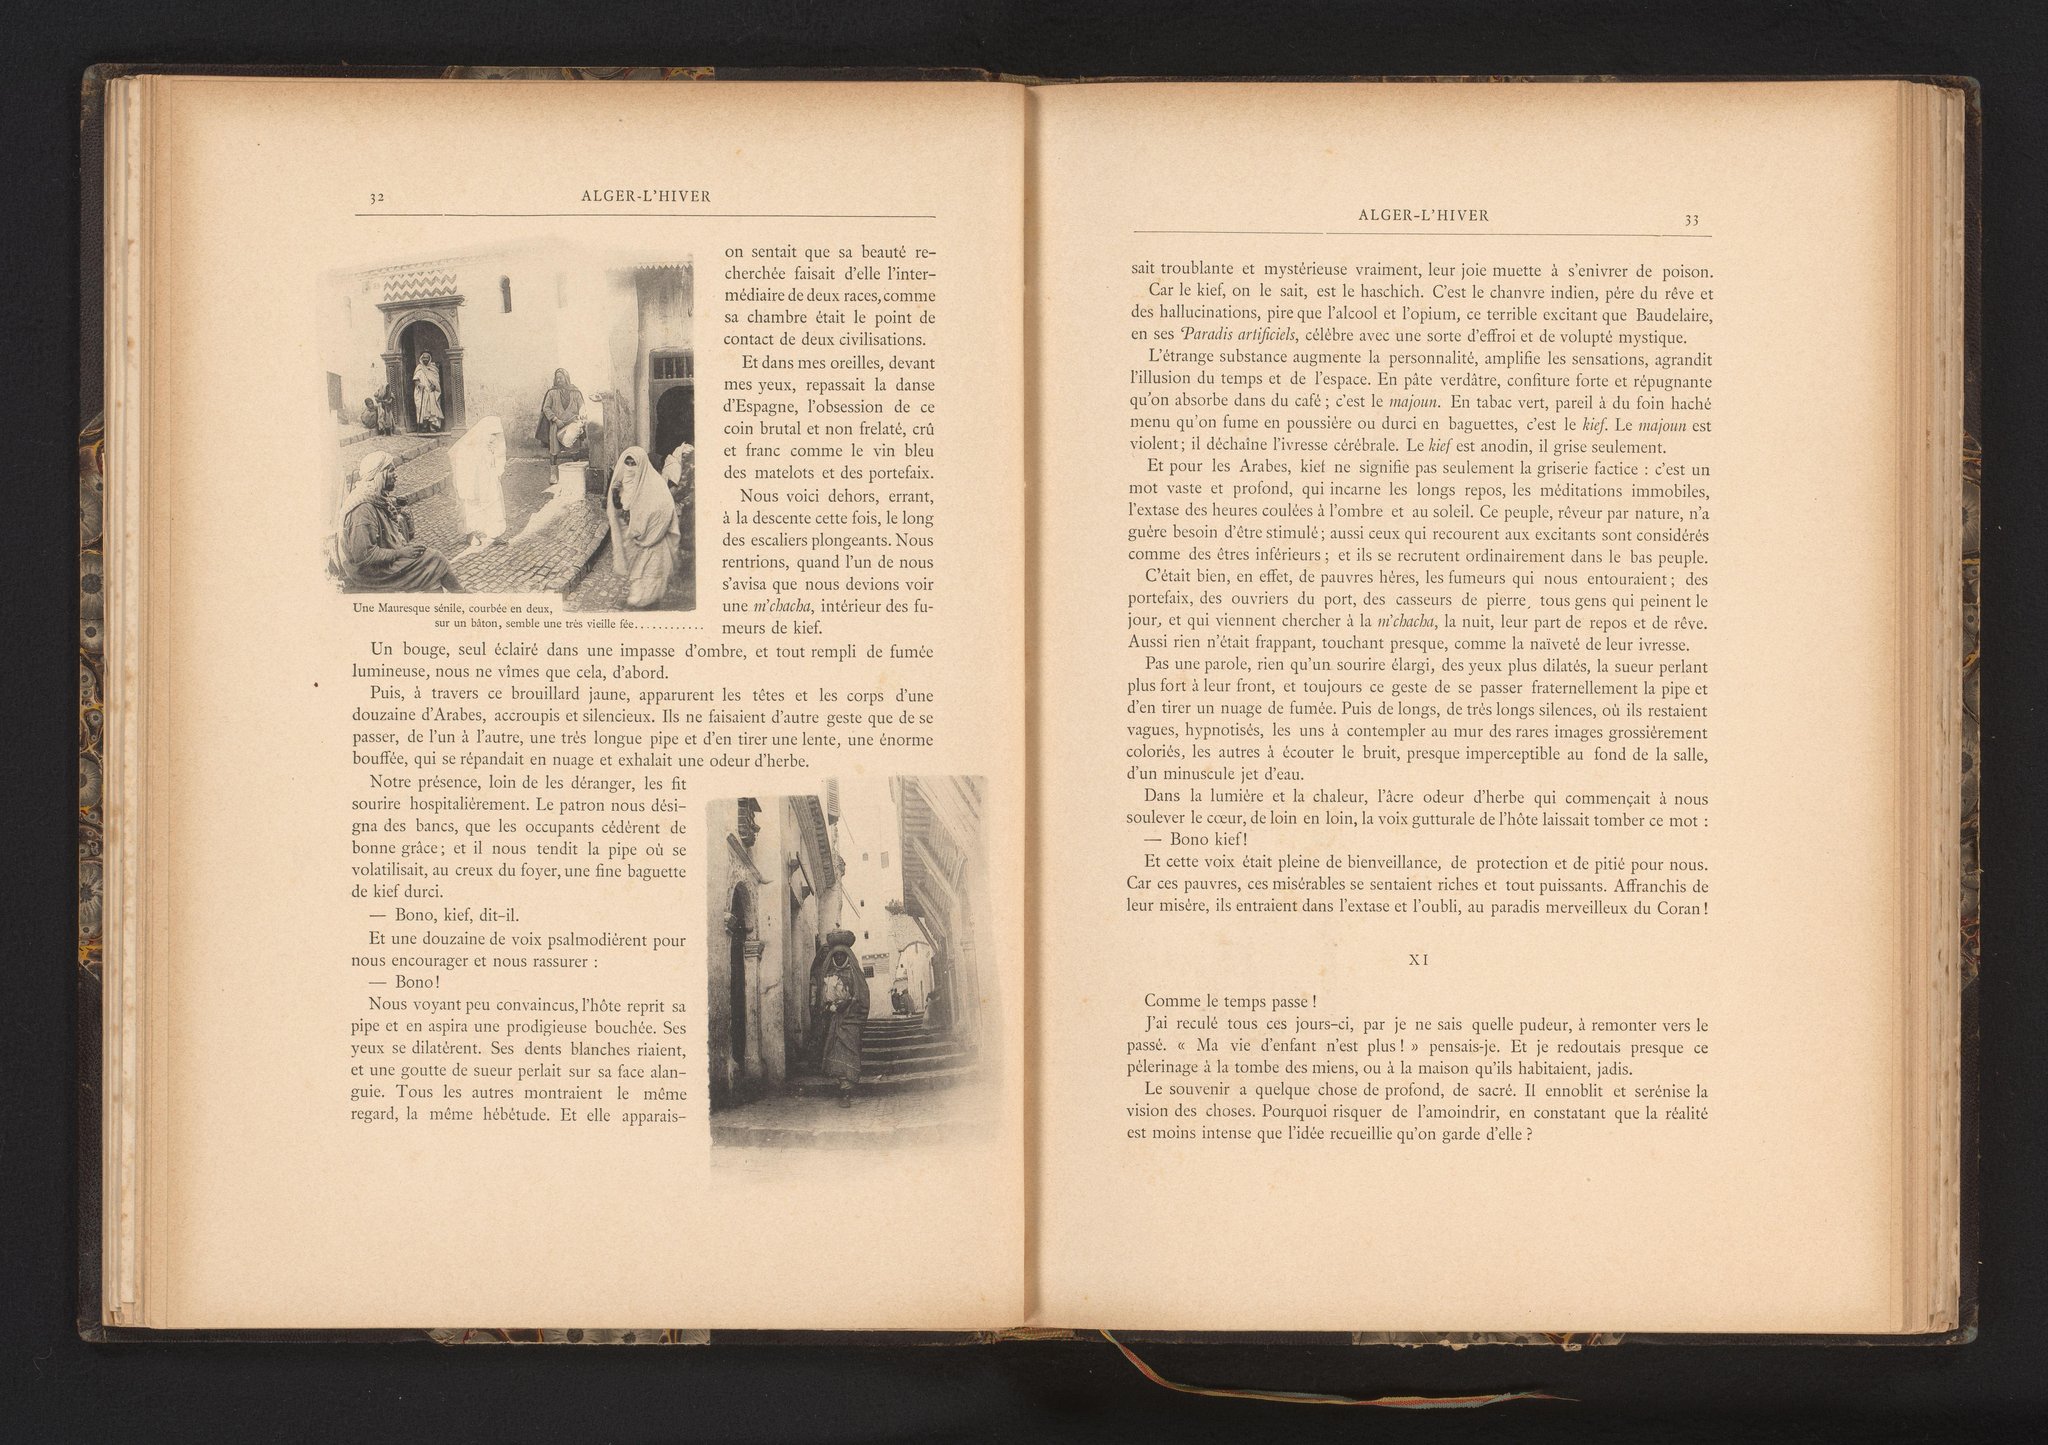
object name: page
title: Mensen dragen spullen op het hoofd in een straat in de kasba van Algiers, Algerije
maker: jules gervais-courtellemont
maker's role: fotograaf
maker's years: 1863-1931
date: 1888-1893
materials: paper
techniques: photograph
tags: street, carrying something on the head or on the shoulders